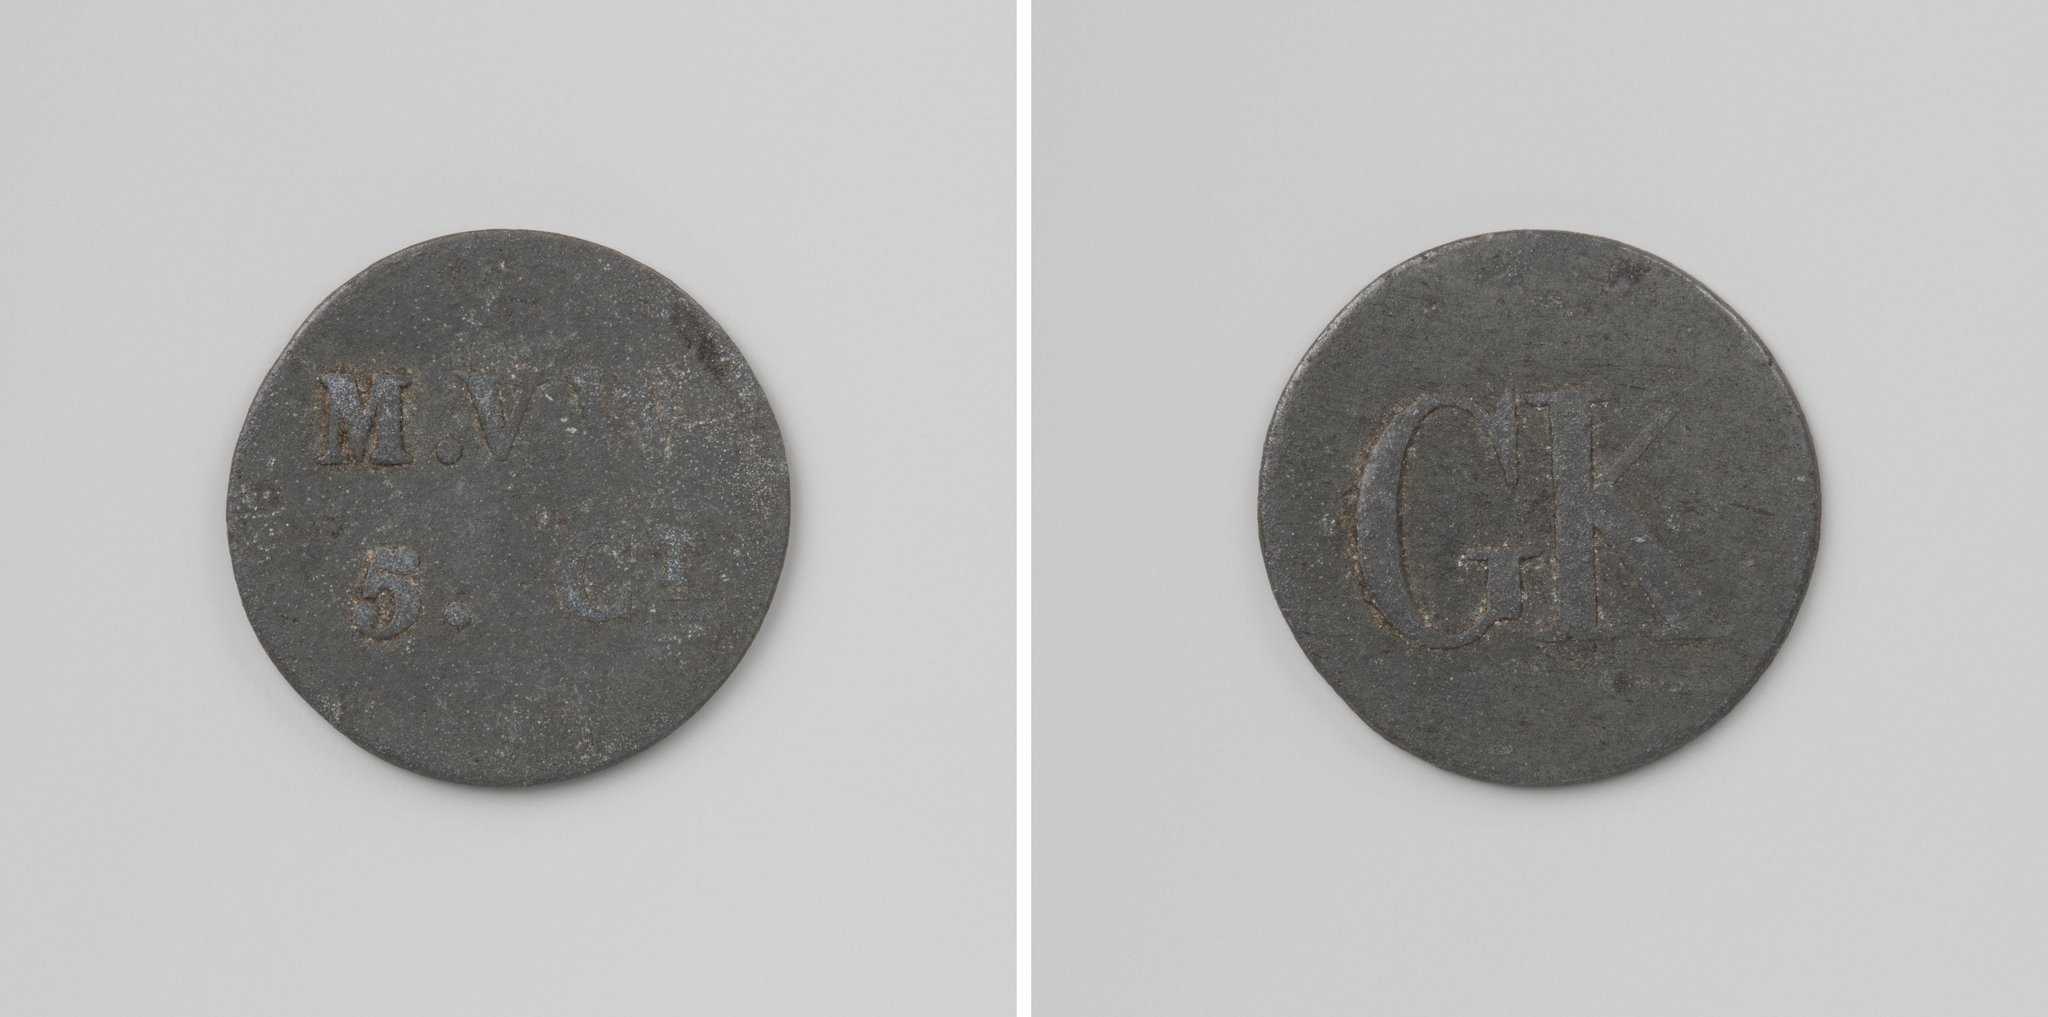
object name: huismunt prison money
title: Huismunt geslagen op last van de Maatschappij van Weldadigheid ter waarde van vijf cent, ten behoeve van de Gewone Koloniën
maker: Anonymous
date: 1818-1859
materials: zinc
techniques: striking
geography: netherlands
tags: maatschappij van weldadigheid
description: Zinken munt. Voorzijde: opschrift boven waardeaanduiding. Keerzijde: opschrift G en K.